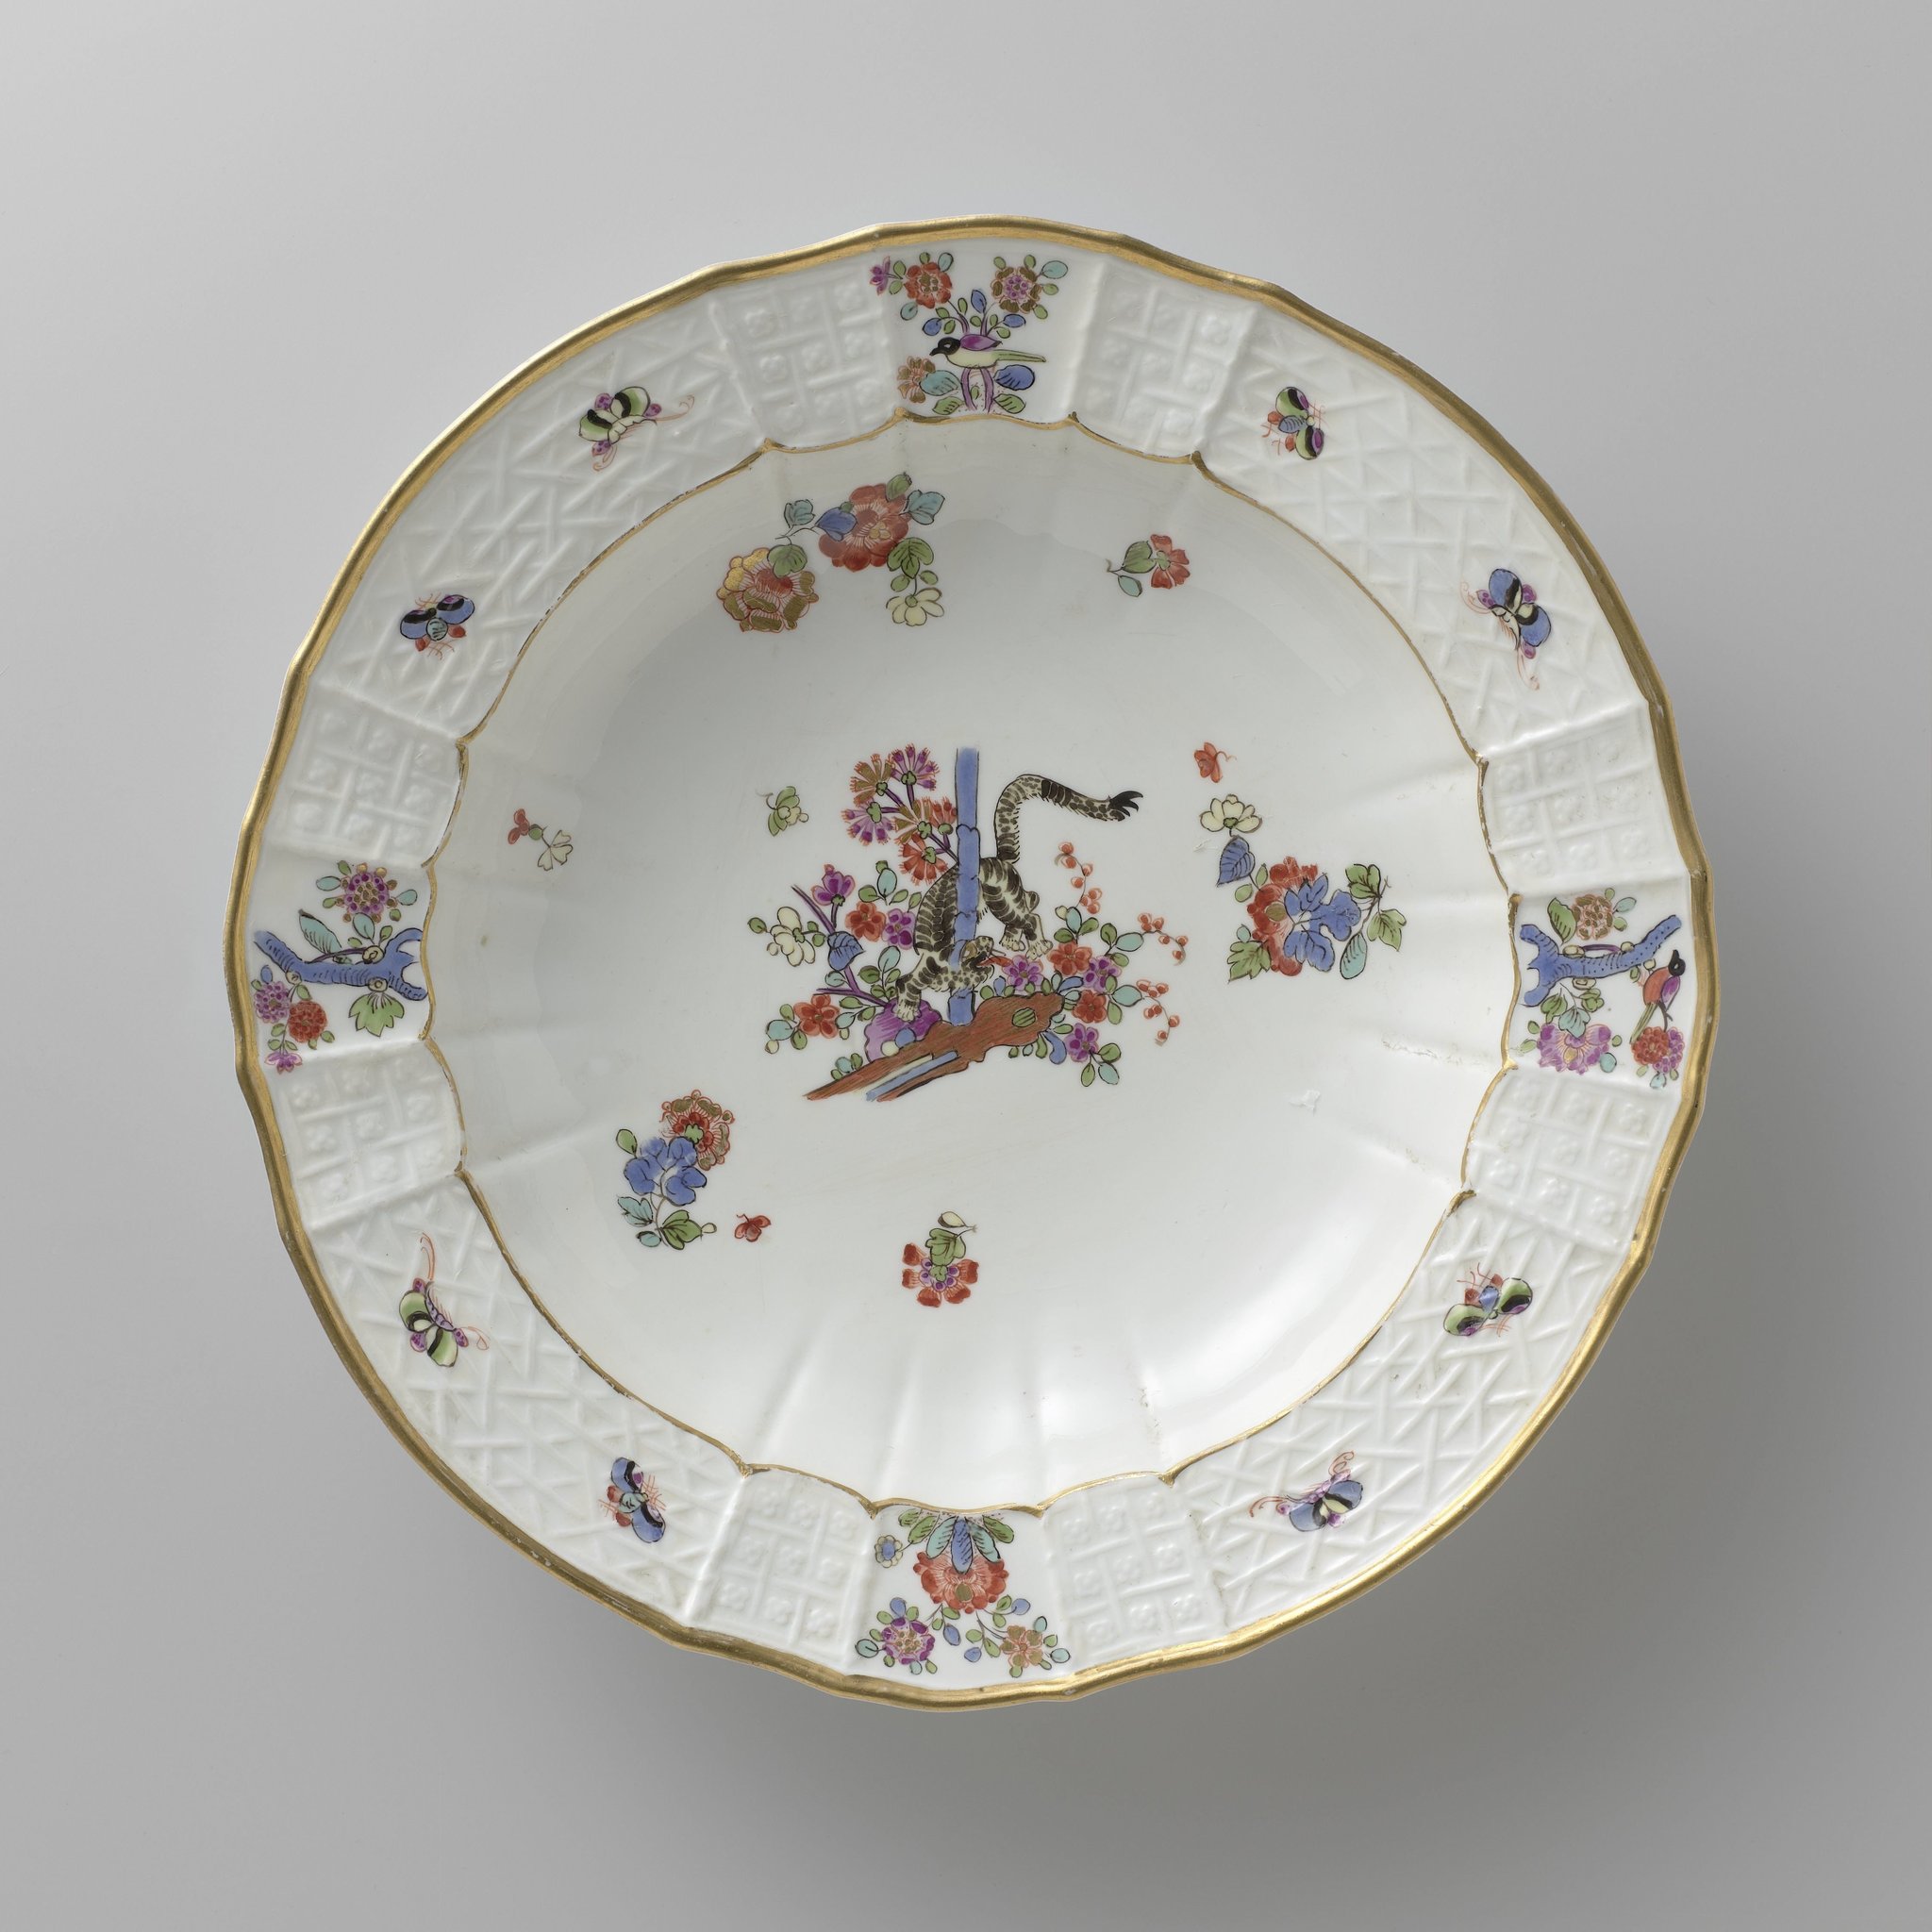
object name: soup plate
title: Soepbord, veelkleurig beschilderd met een Kakiemon-decor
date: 1740-1745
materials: porcelain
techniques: painted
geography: meissen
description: Soepbord van beschilderd porselein. Het bord heeft een geribde en geschulpte rand. Het bord is beschilderd met een tijger, die zich tussen bloemen om een bamboestengel draait, gestrooide Indianische Blumen, vlinders en takken met vogels. De rand is versierd met het 'Altbrandenstein'-patroon. Het bord is gemerkt.